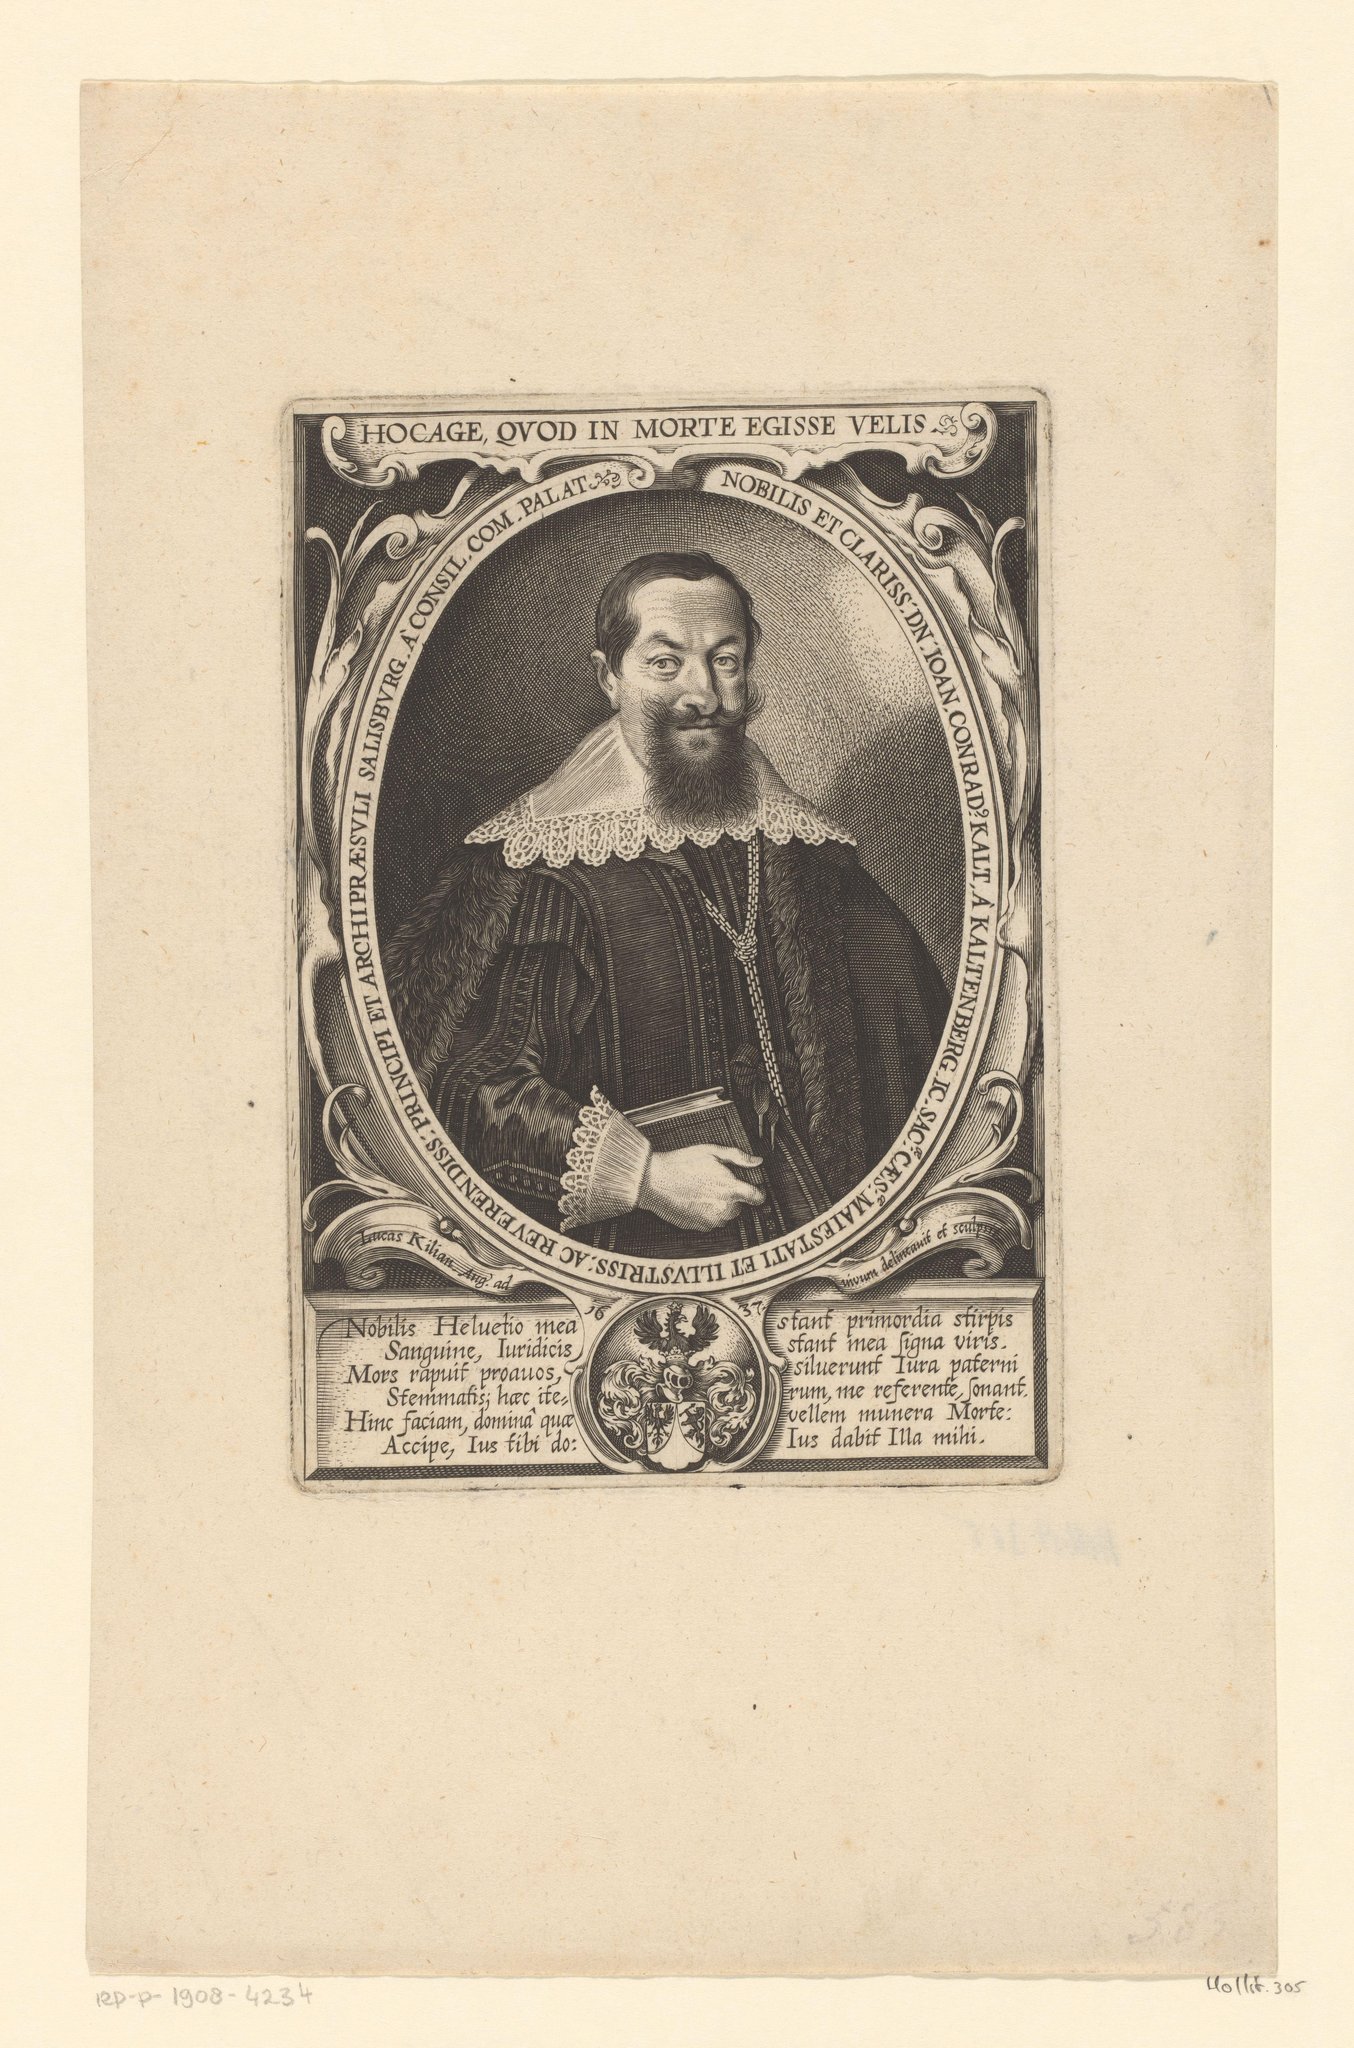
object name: print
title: Portret van Johann Conrad Kalt von Kaltenberg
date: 1637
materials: paper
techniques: engraving, etching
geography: augsburg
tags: historical persons, lawyer, attorney at law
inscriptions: collector's mark: Lugt 2228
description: Tekst in het Latijn in de omlijsting en in de ondermarge.